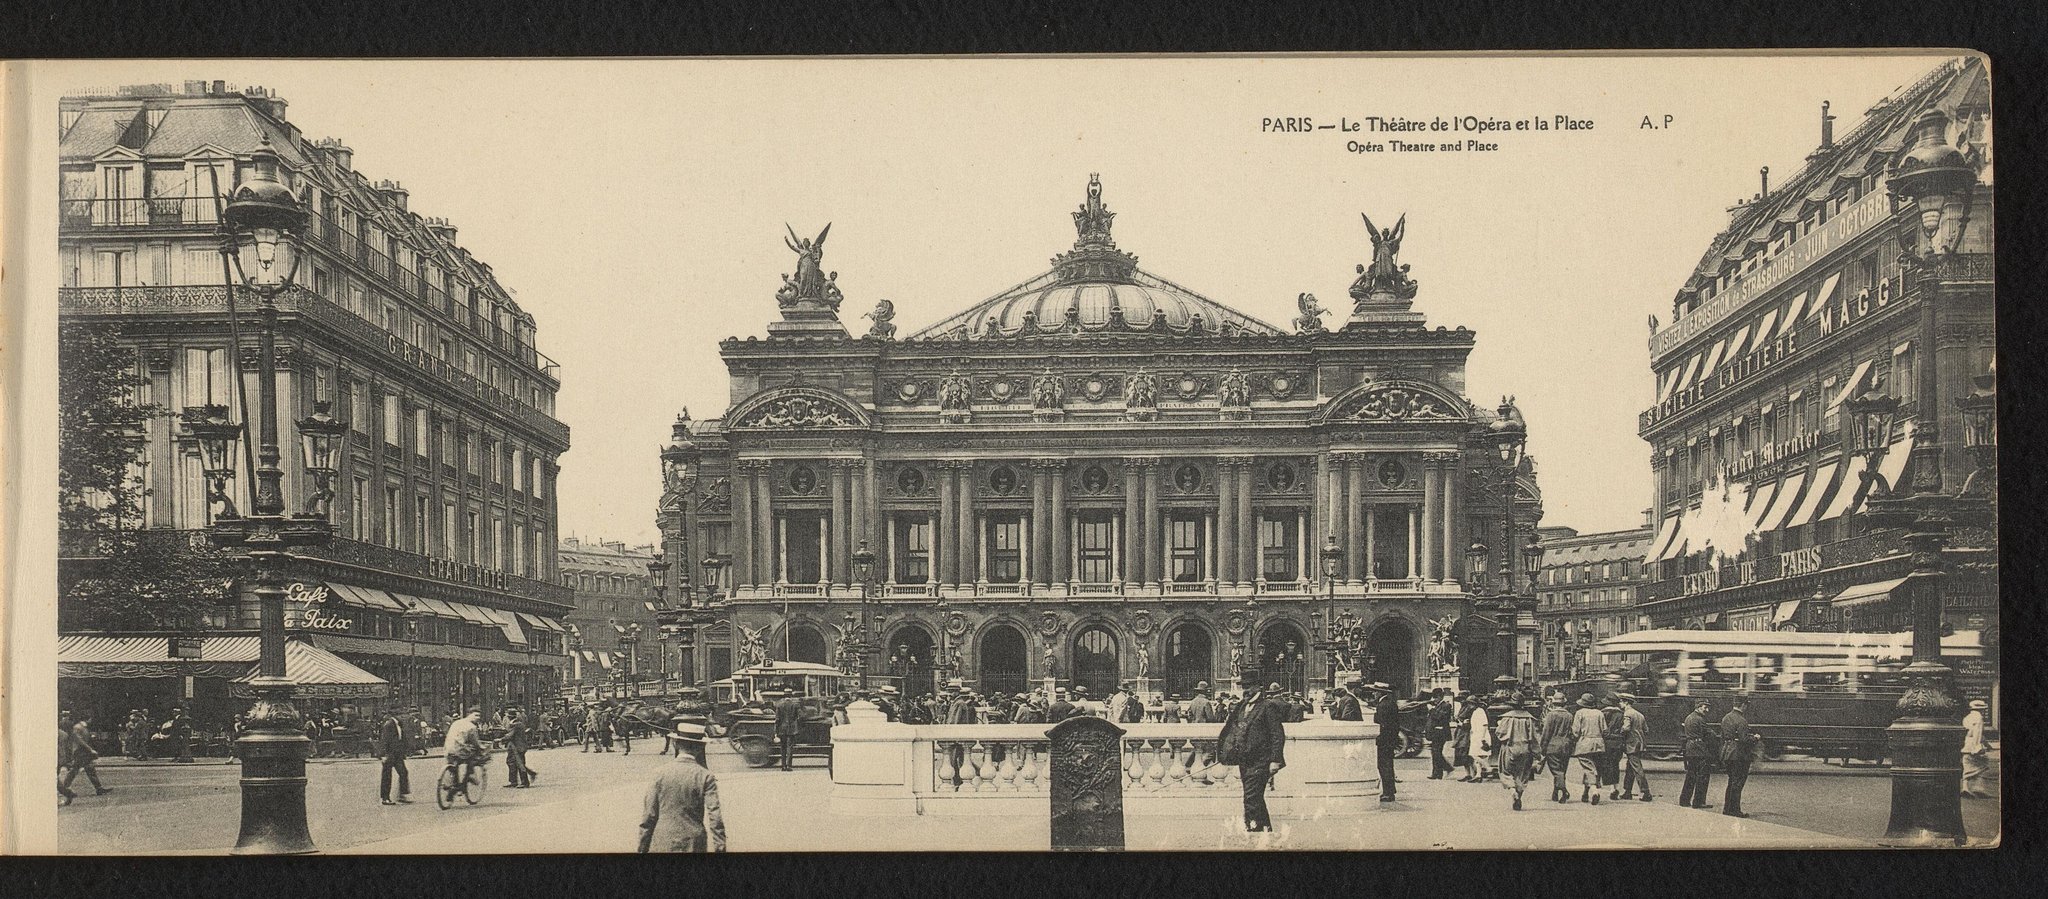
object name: photomechanical print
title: Paris. Le Théâtre de l'Opéra et la Place / Opéra Theatre and Place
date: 1910-1925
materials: cardboard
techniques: photograph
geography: paris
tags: square, place, circus, etc. (+ city(-scape) with figures, staffage), opera house